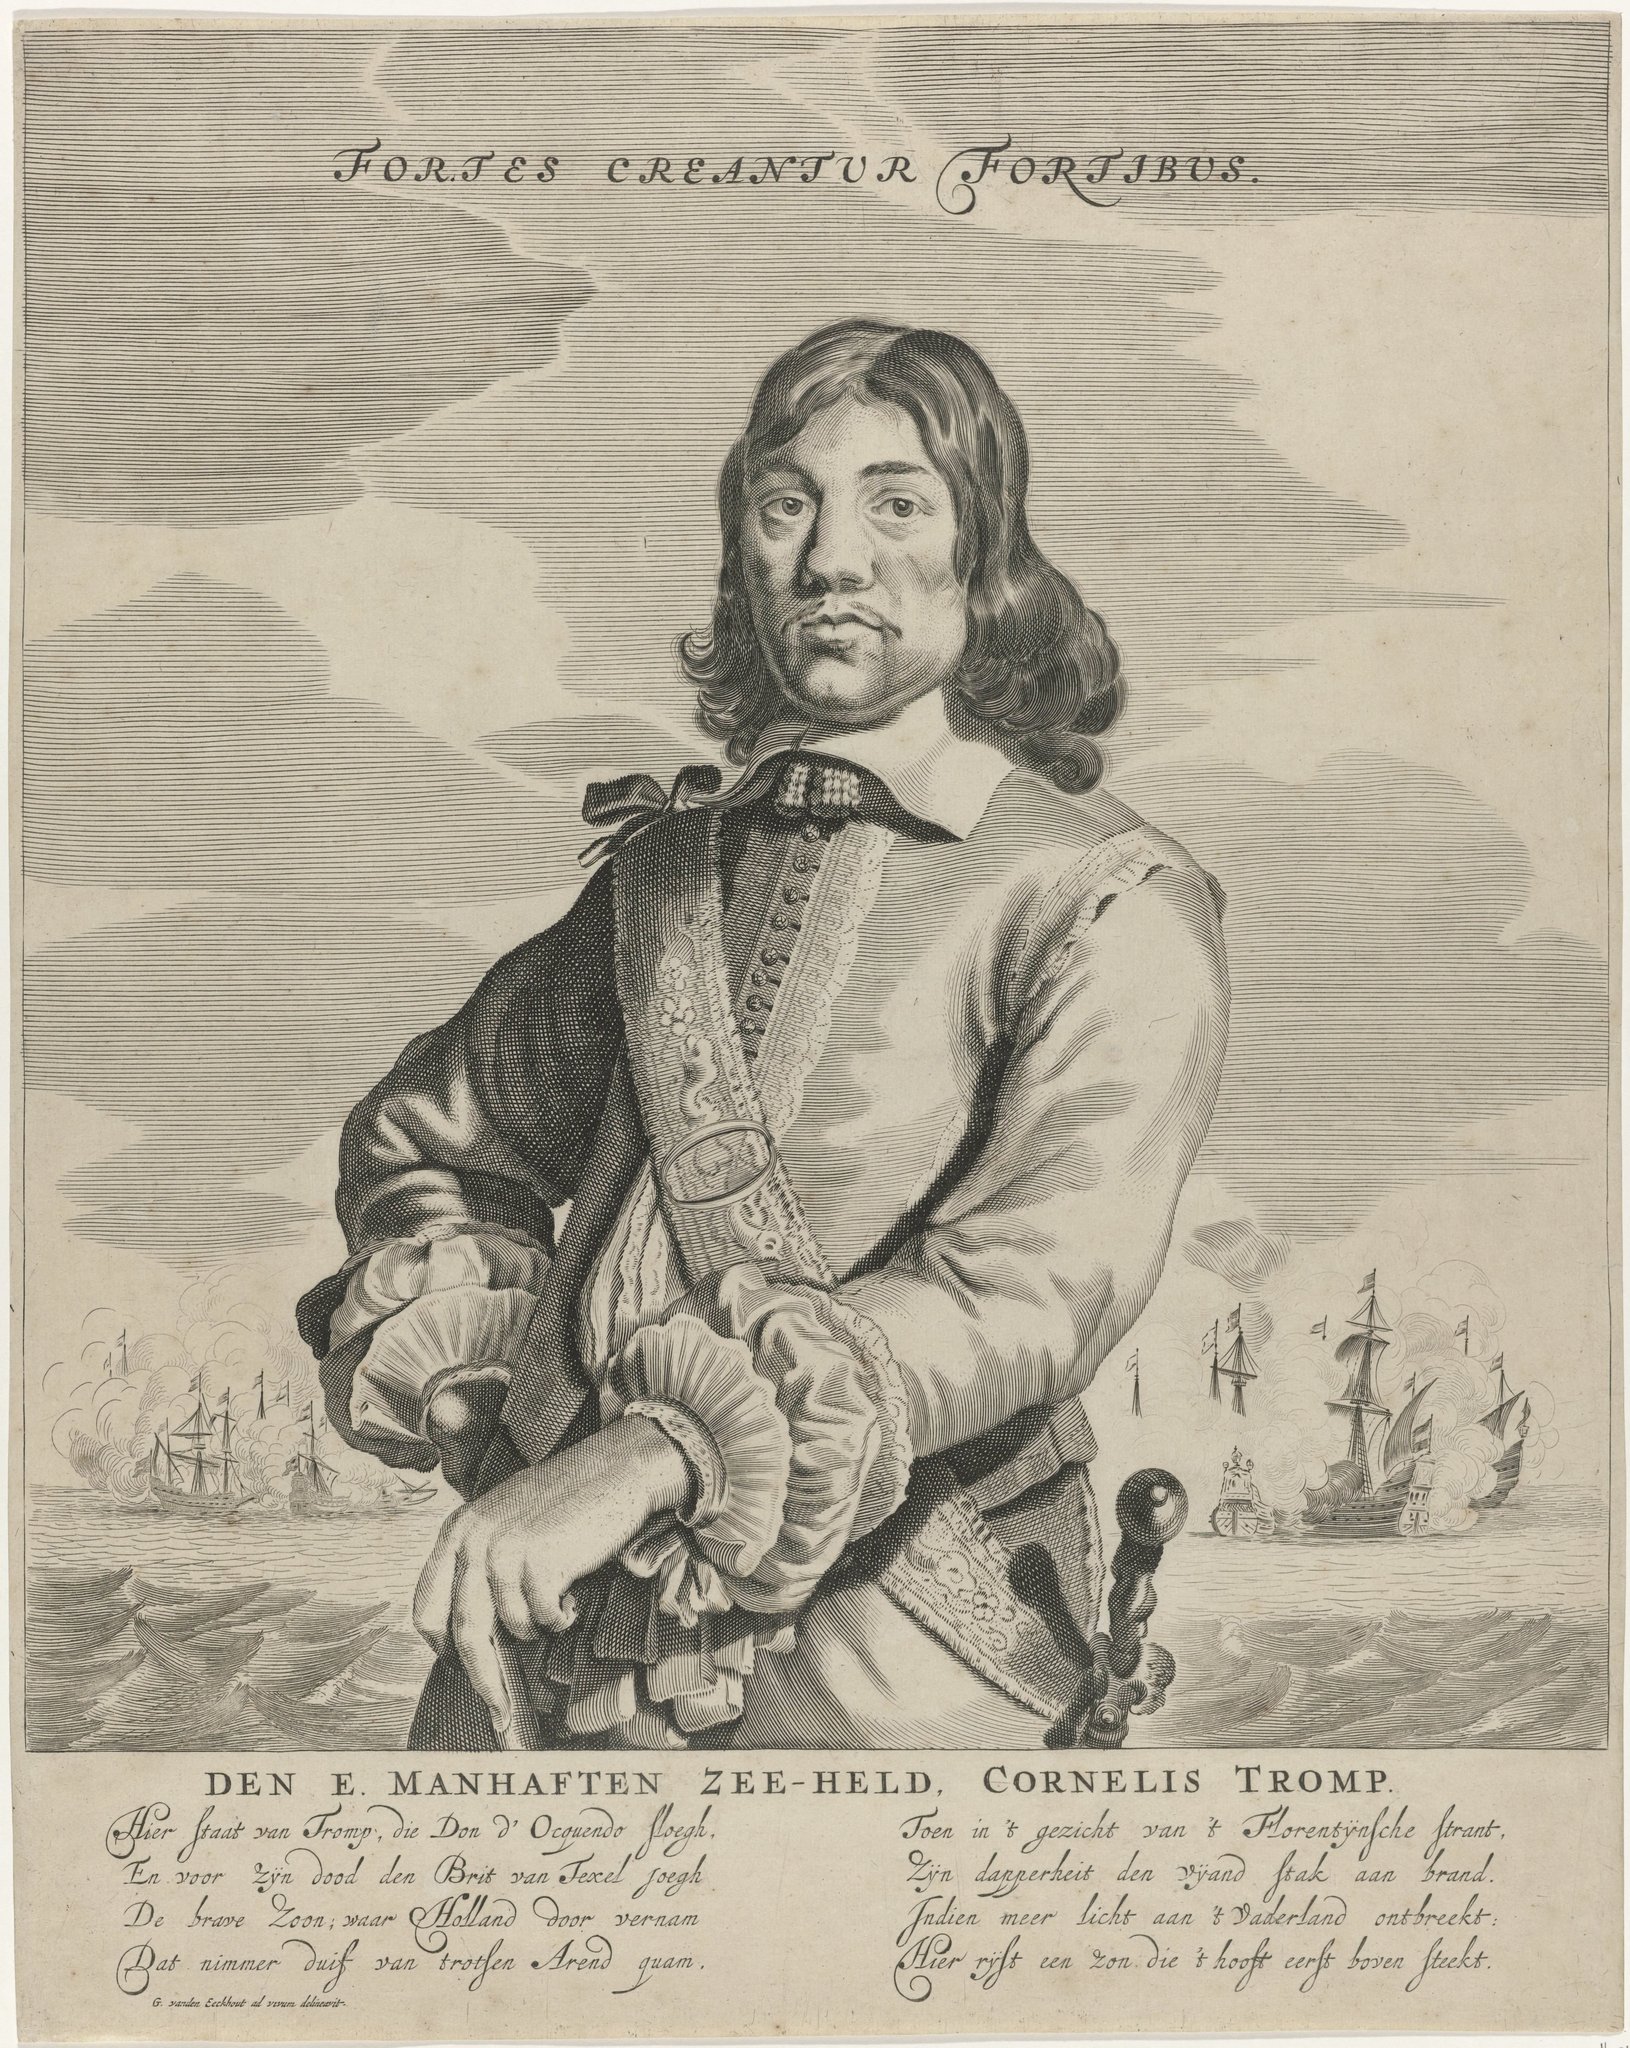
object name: print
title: Portret van Cornelis Tromp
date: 1640-1655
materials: paper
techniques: engraving, etching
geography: amsterdam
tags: rotterdam, amsterdam, cornelis tromp, battle, fighting in general (+ naval force)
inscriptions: collector's mark: Lugt 2228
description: Portret van vlootvoogd Cornelis Tromp. Op de achtergrond een zeeslag. Midden boven de spreuk: Fortes Creantur Fortibus, wat betekent: Sterken brengen sterken voort. Cornelis Tromp was de zoon van Nederlands admiraal Maarten Harpertszoon Tromp. Onderaan in de marge twee vierregelige verzen in het Nederlands.